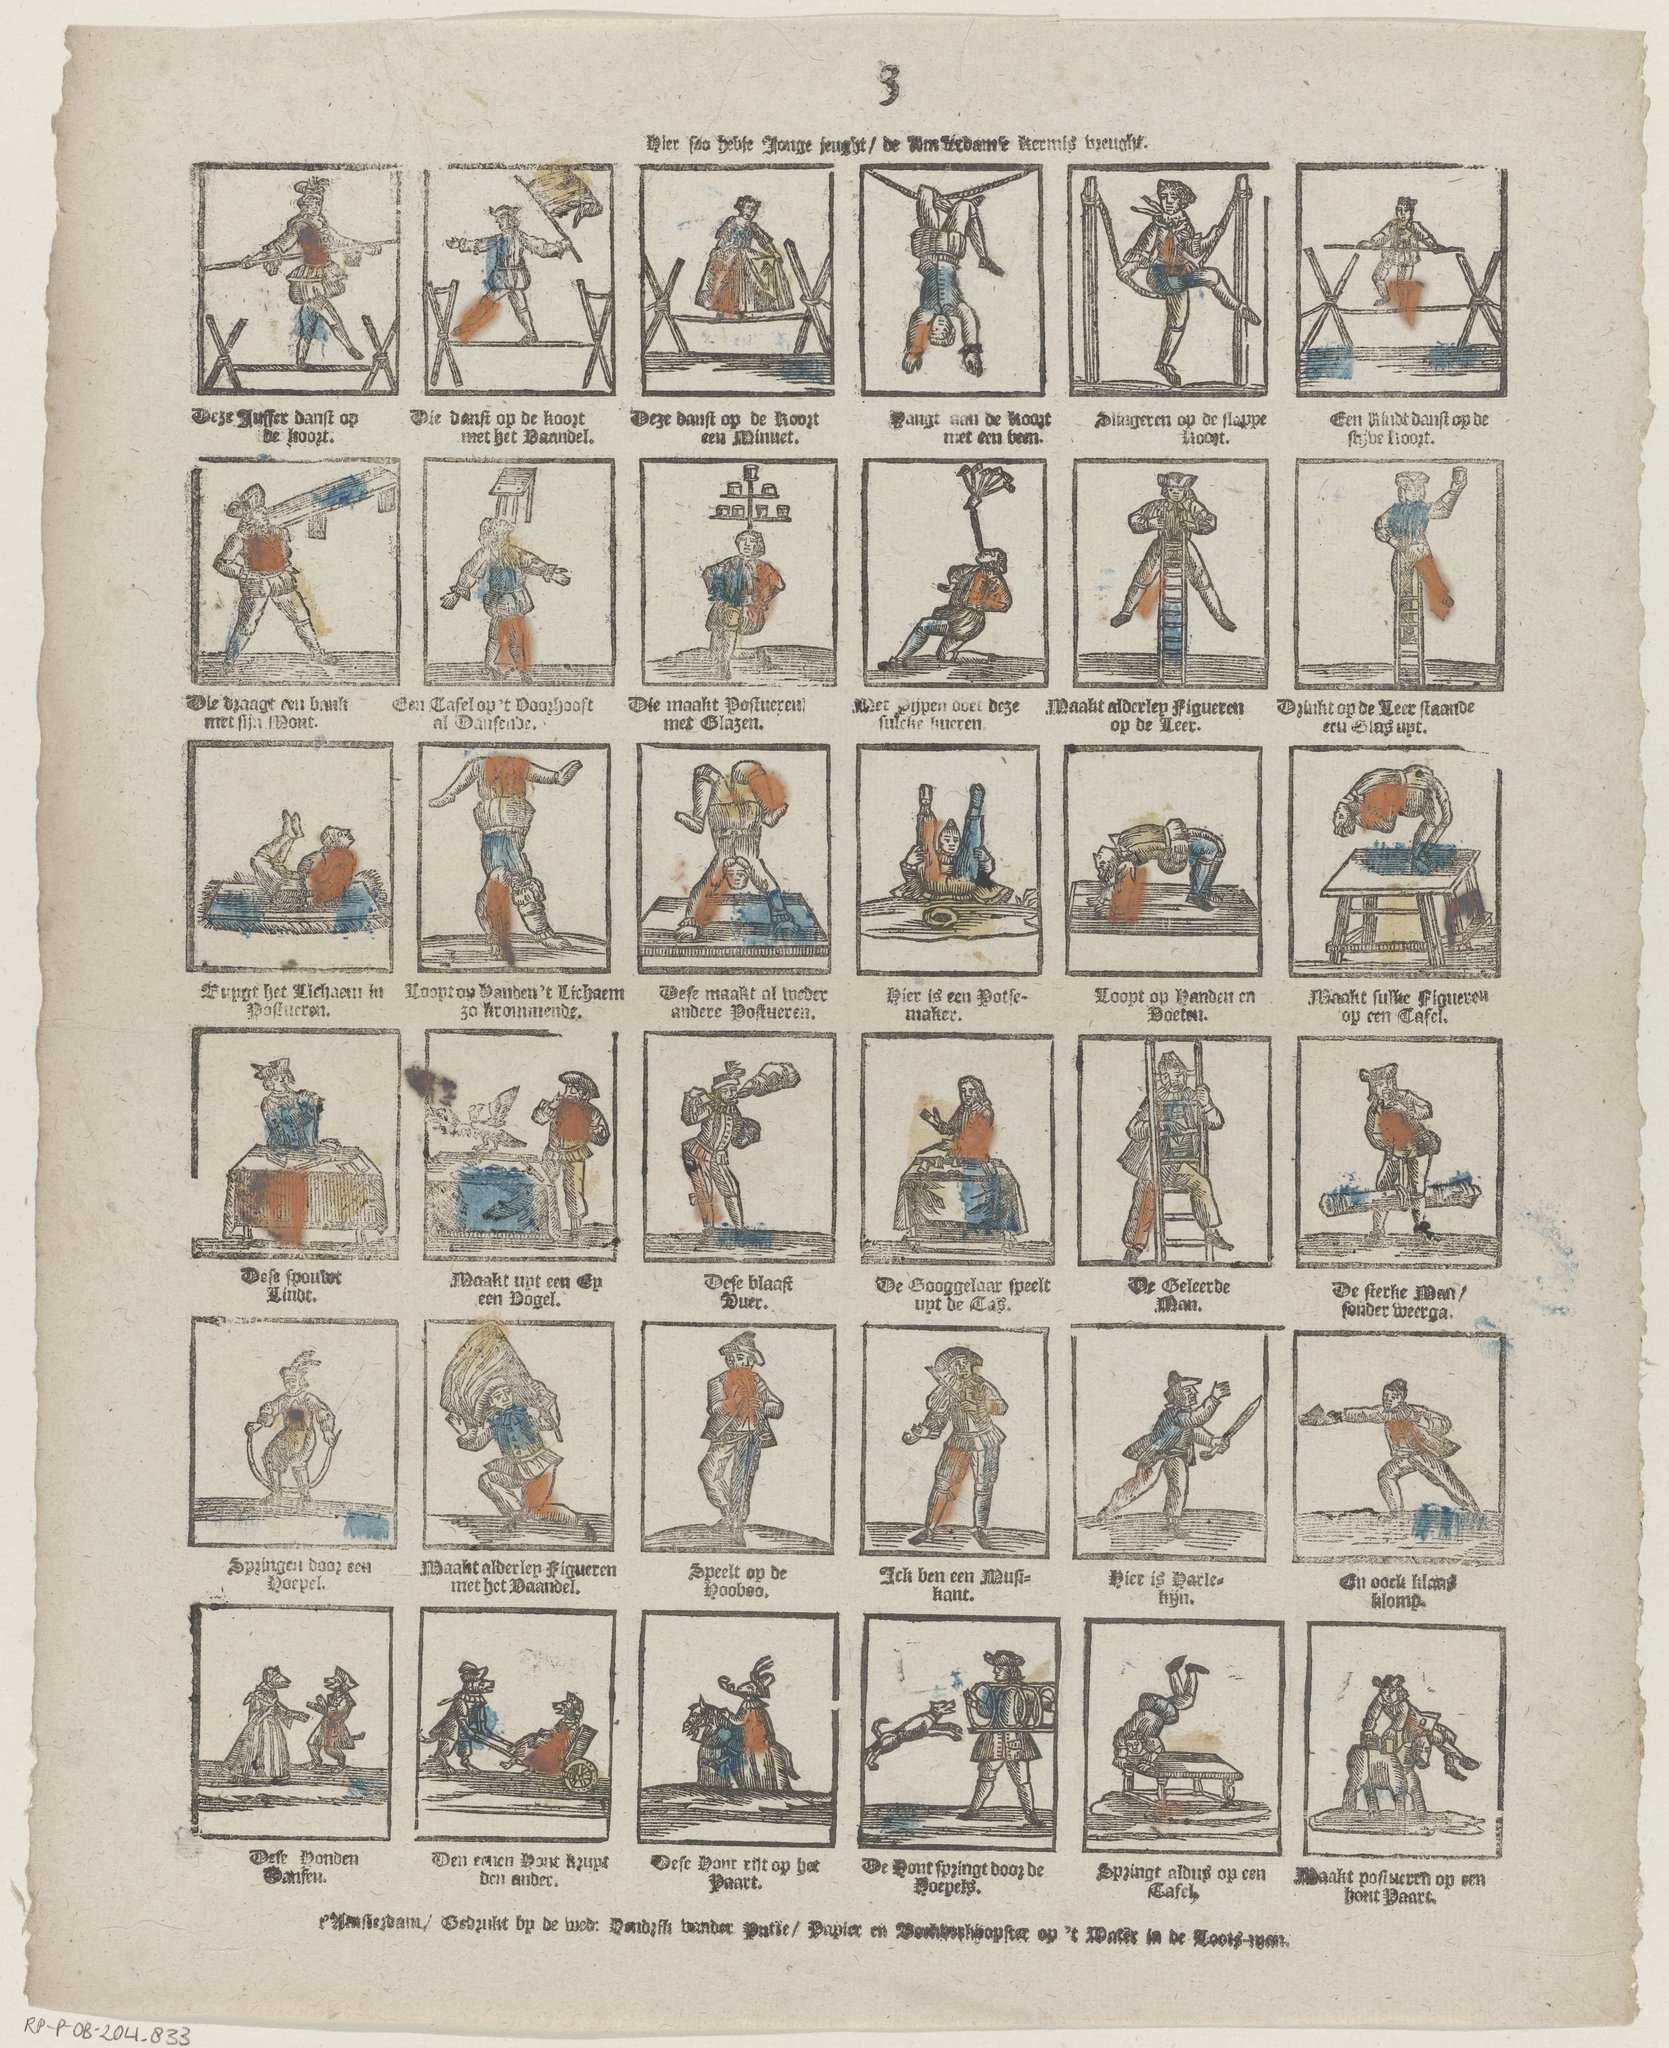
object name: print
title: Hier soo hebje jonge jeught / de Amsterdamse kermis vreught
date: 1765-1767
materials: paper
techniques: colour, letterpress printing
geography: amsterdam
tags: street-trader, pleasure fair and circus, amsterdam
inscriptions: collector's mark: Lugt 2760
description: Blad met 36 taferelen op de Amsterdamse kermis. Onder elke afbeelding een onderschrift. Genummerd midden boven: 3.